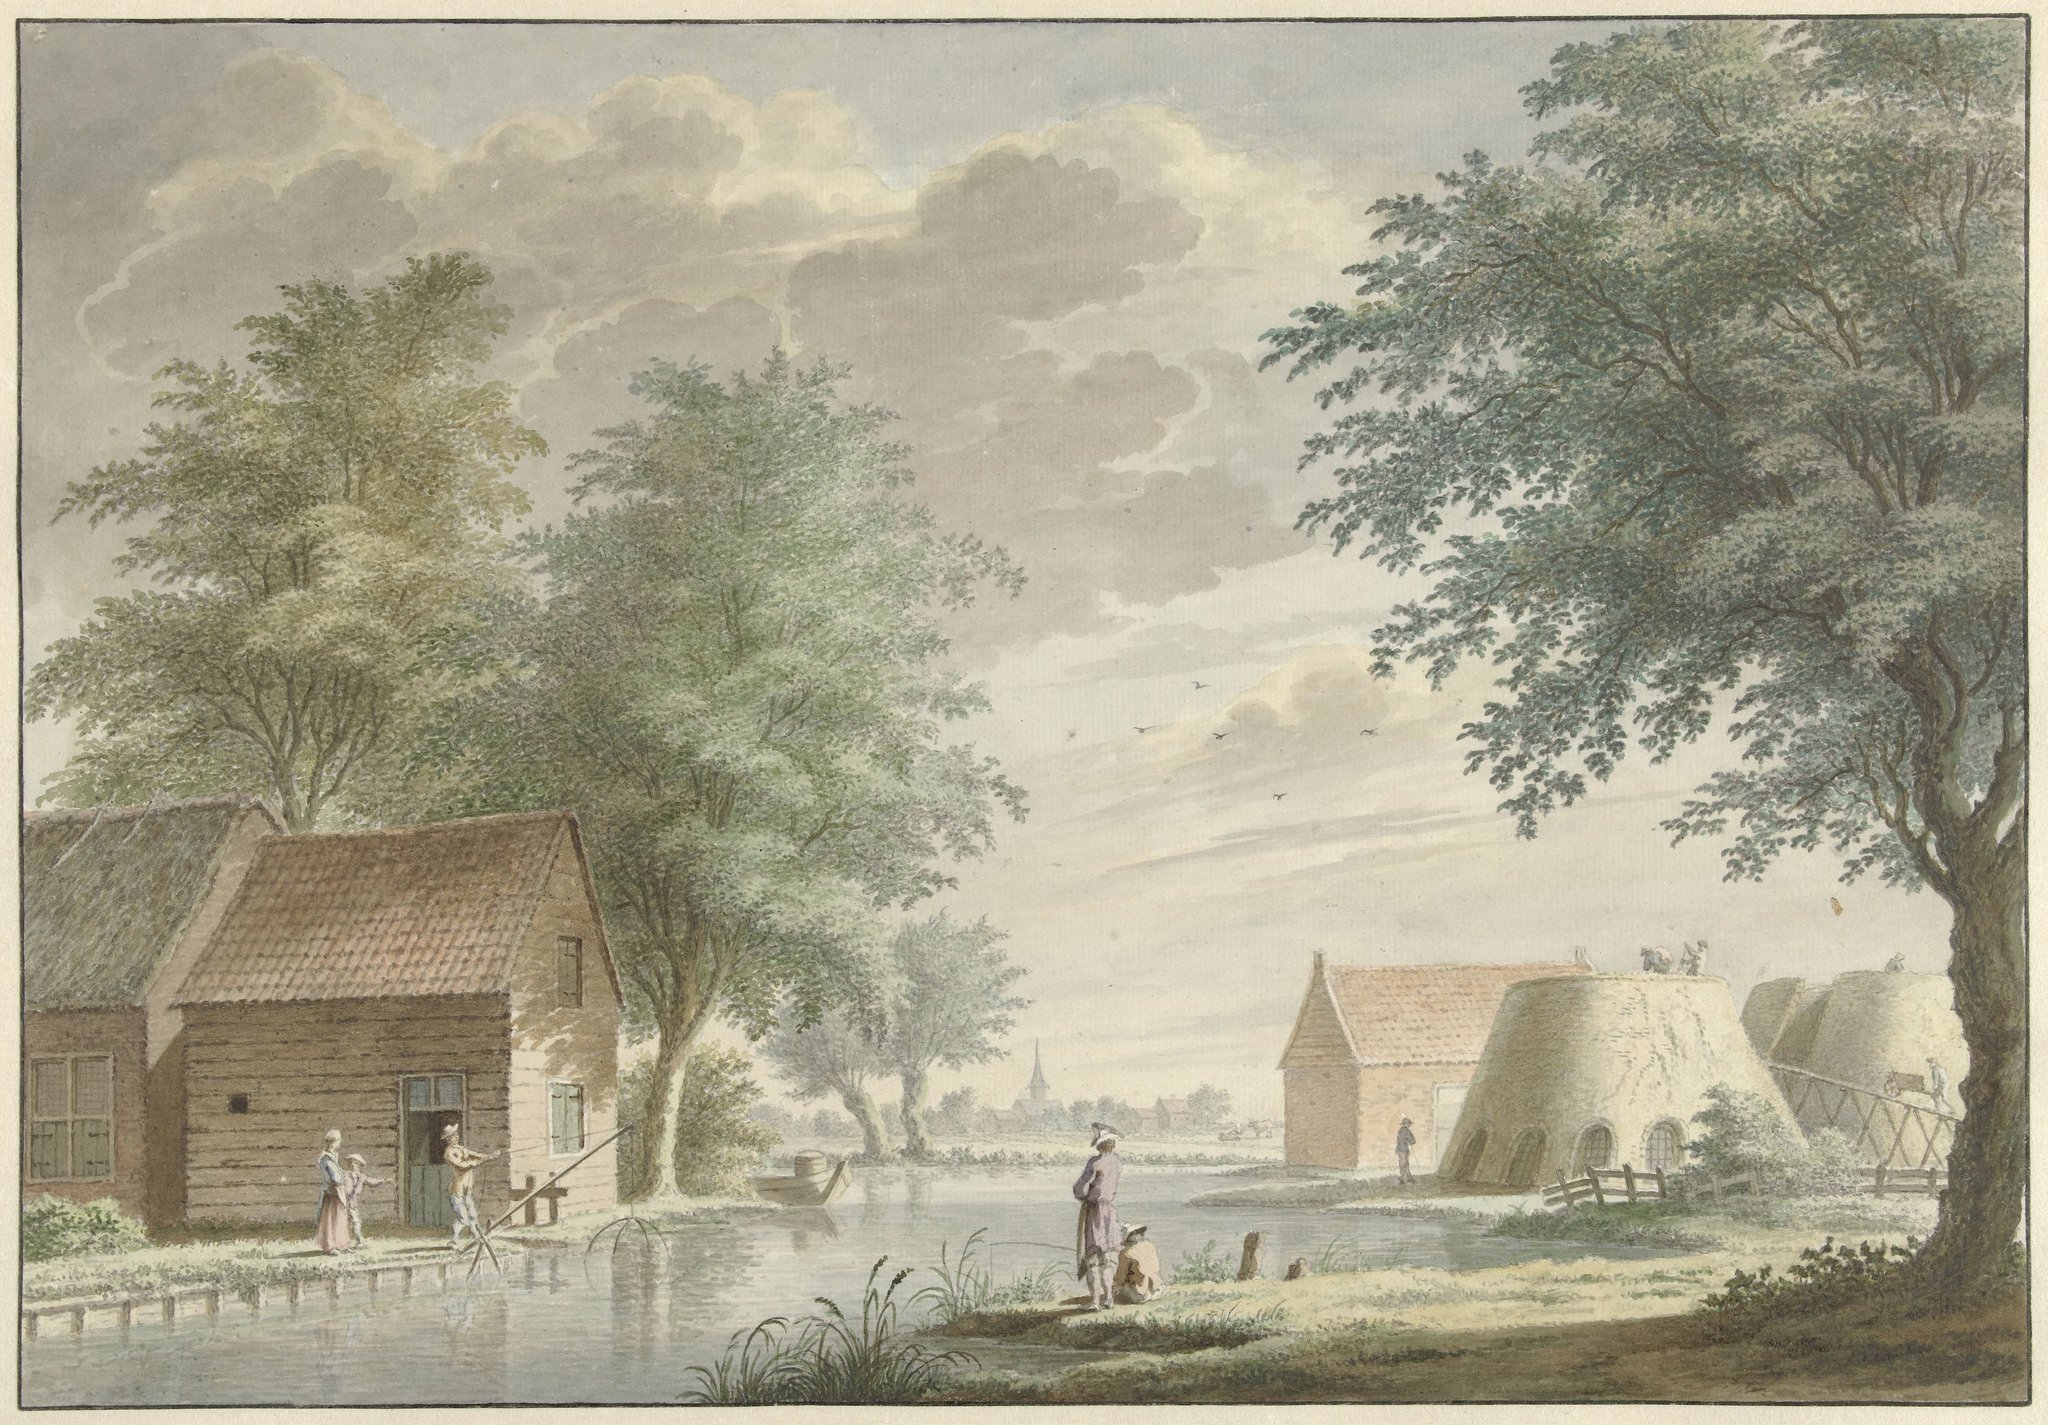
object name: drawing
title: Kalkovens bij Hillegom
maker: gerard van rossum (1698/99-1772)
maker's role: draughtsman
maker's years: 1698-1772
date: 1765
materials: paper, watercolor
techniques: brush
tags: industries ~ clay, sand, chalk, etc.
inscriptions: : ‘Gezigt aan de Kalkovens bij Hillegom’, name: ‘GV.Rossum.’